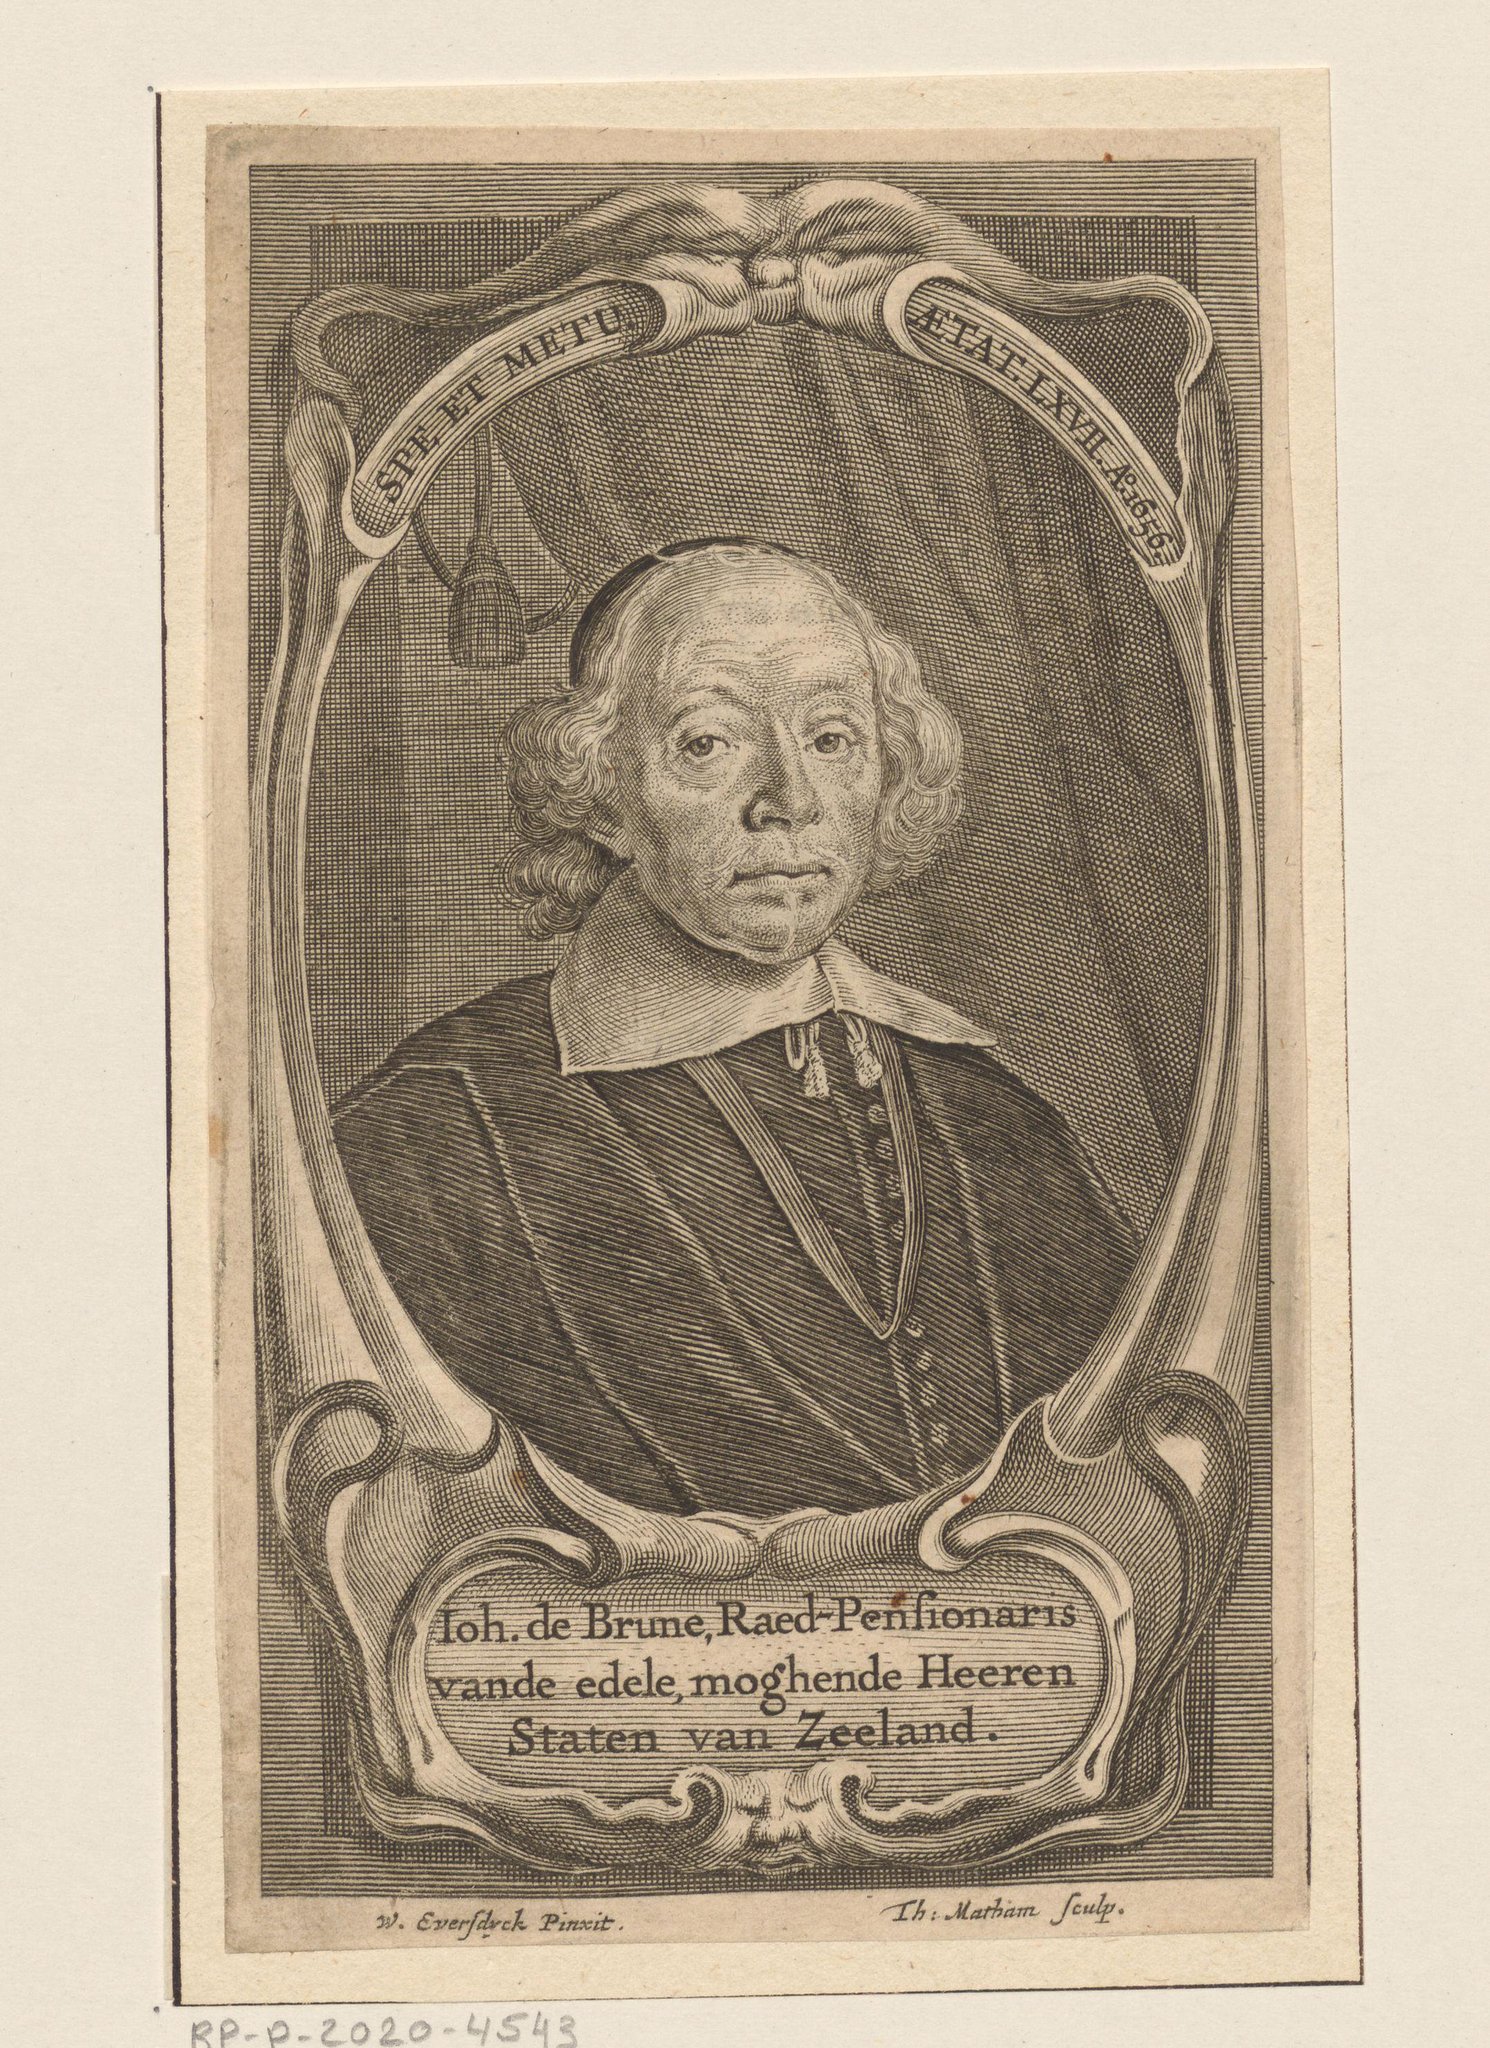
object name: book illustration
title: Portret van Johan de Brune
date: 1657-1660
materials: paper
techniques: engraving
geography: middelburg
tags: middelburg, johan de brune (i), historical persons, portrait of a writer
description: Prent gebruikt in: Brune, Johan de. Het eerste deel van 't bancket-werck van goede gedachten. Middelburg: Jaques Fierens, 1657. Prent ook gebruikt in de 1660-editie.